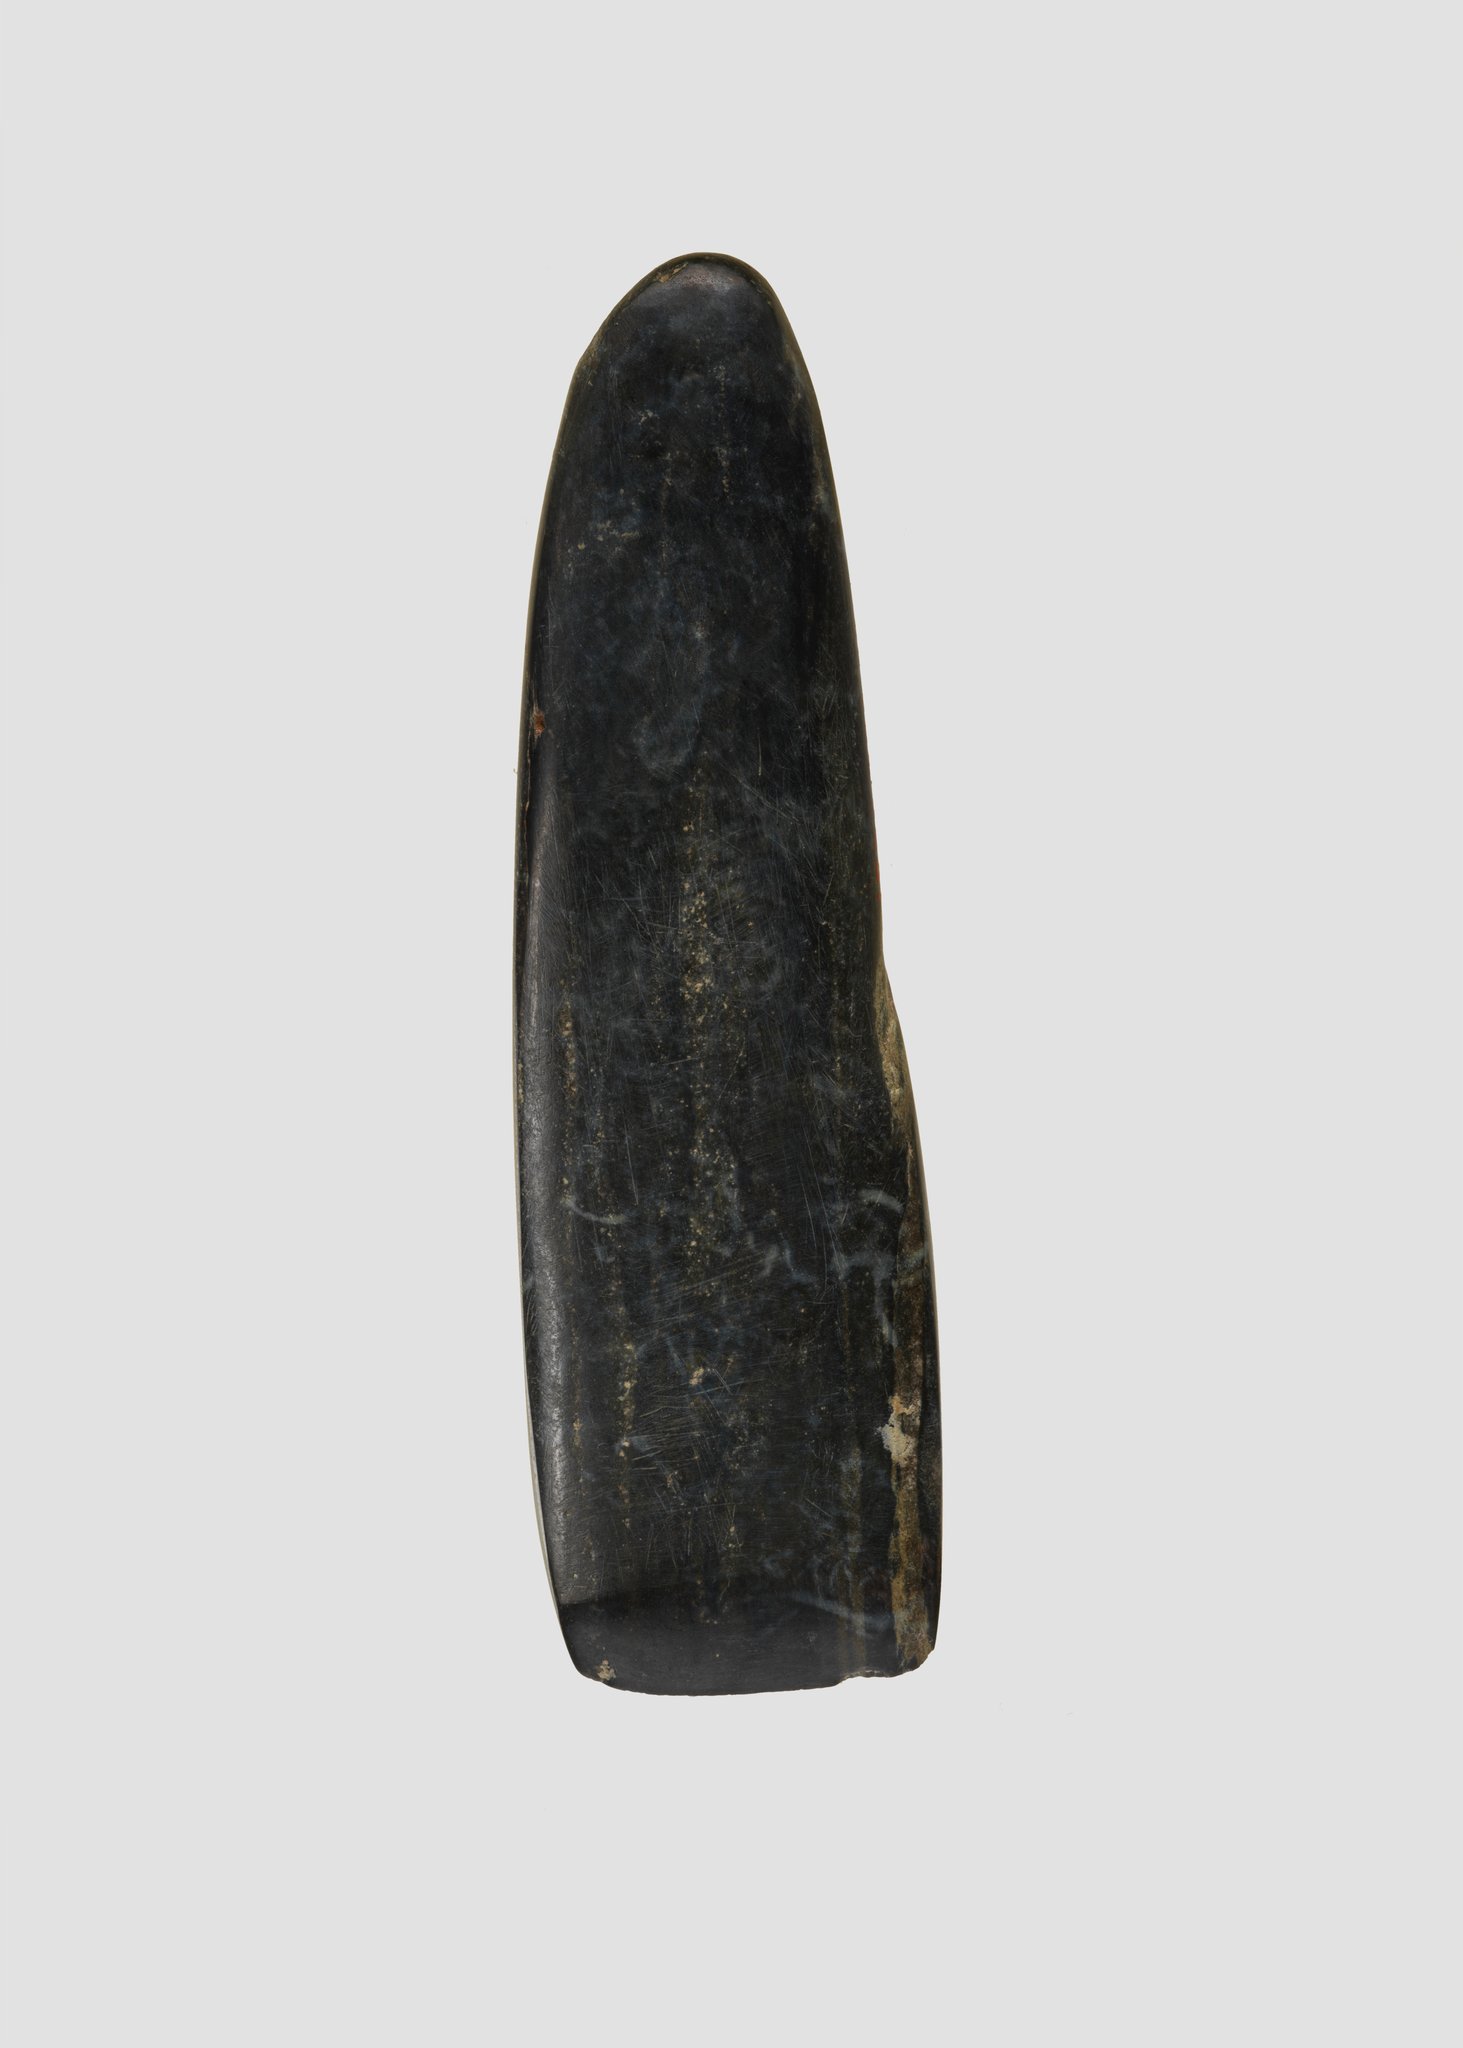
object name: celt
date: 7000-5001 BCE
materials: stone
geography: syria